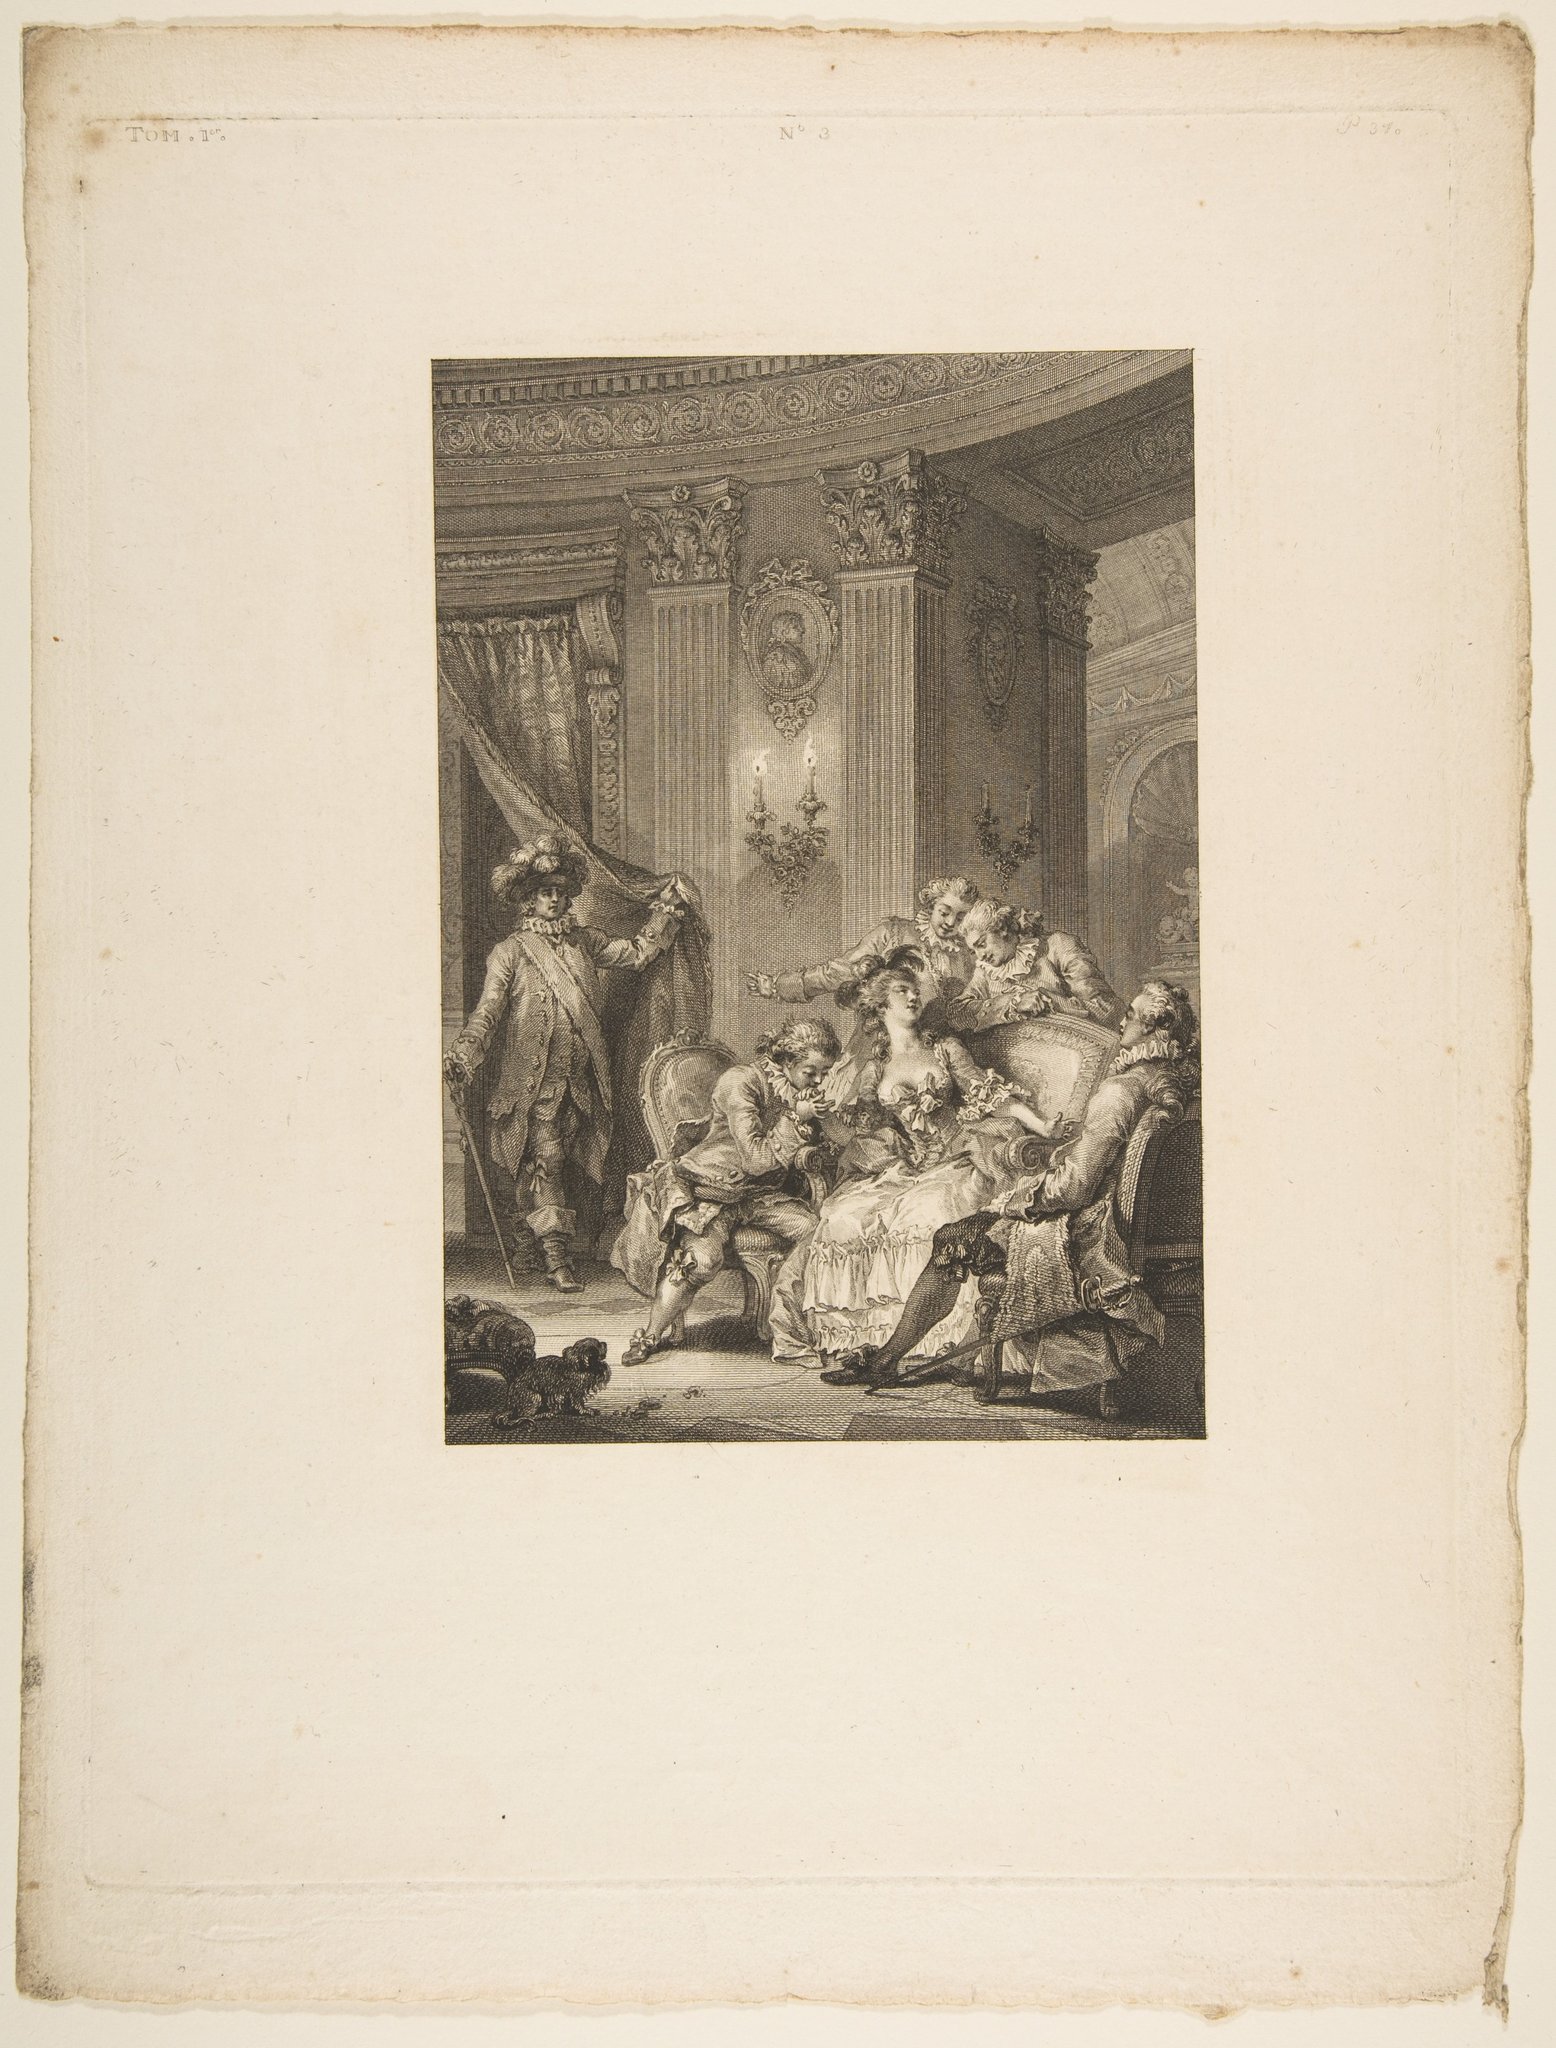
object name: print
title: Le Mari Confesseur, from "Contes et nouvelles en vers par Jean de La Fontaine. A Paris, de l'imprimerie de P. Didot, l'an III de la République, 1795"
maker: jean-baptiste tilliard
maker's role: artist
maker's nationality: french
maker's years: 1740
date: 1795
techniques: engraving, etching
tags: men,women